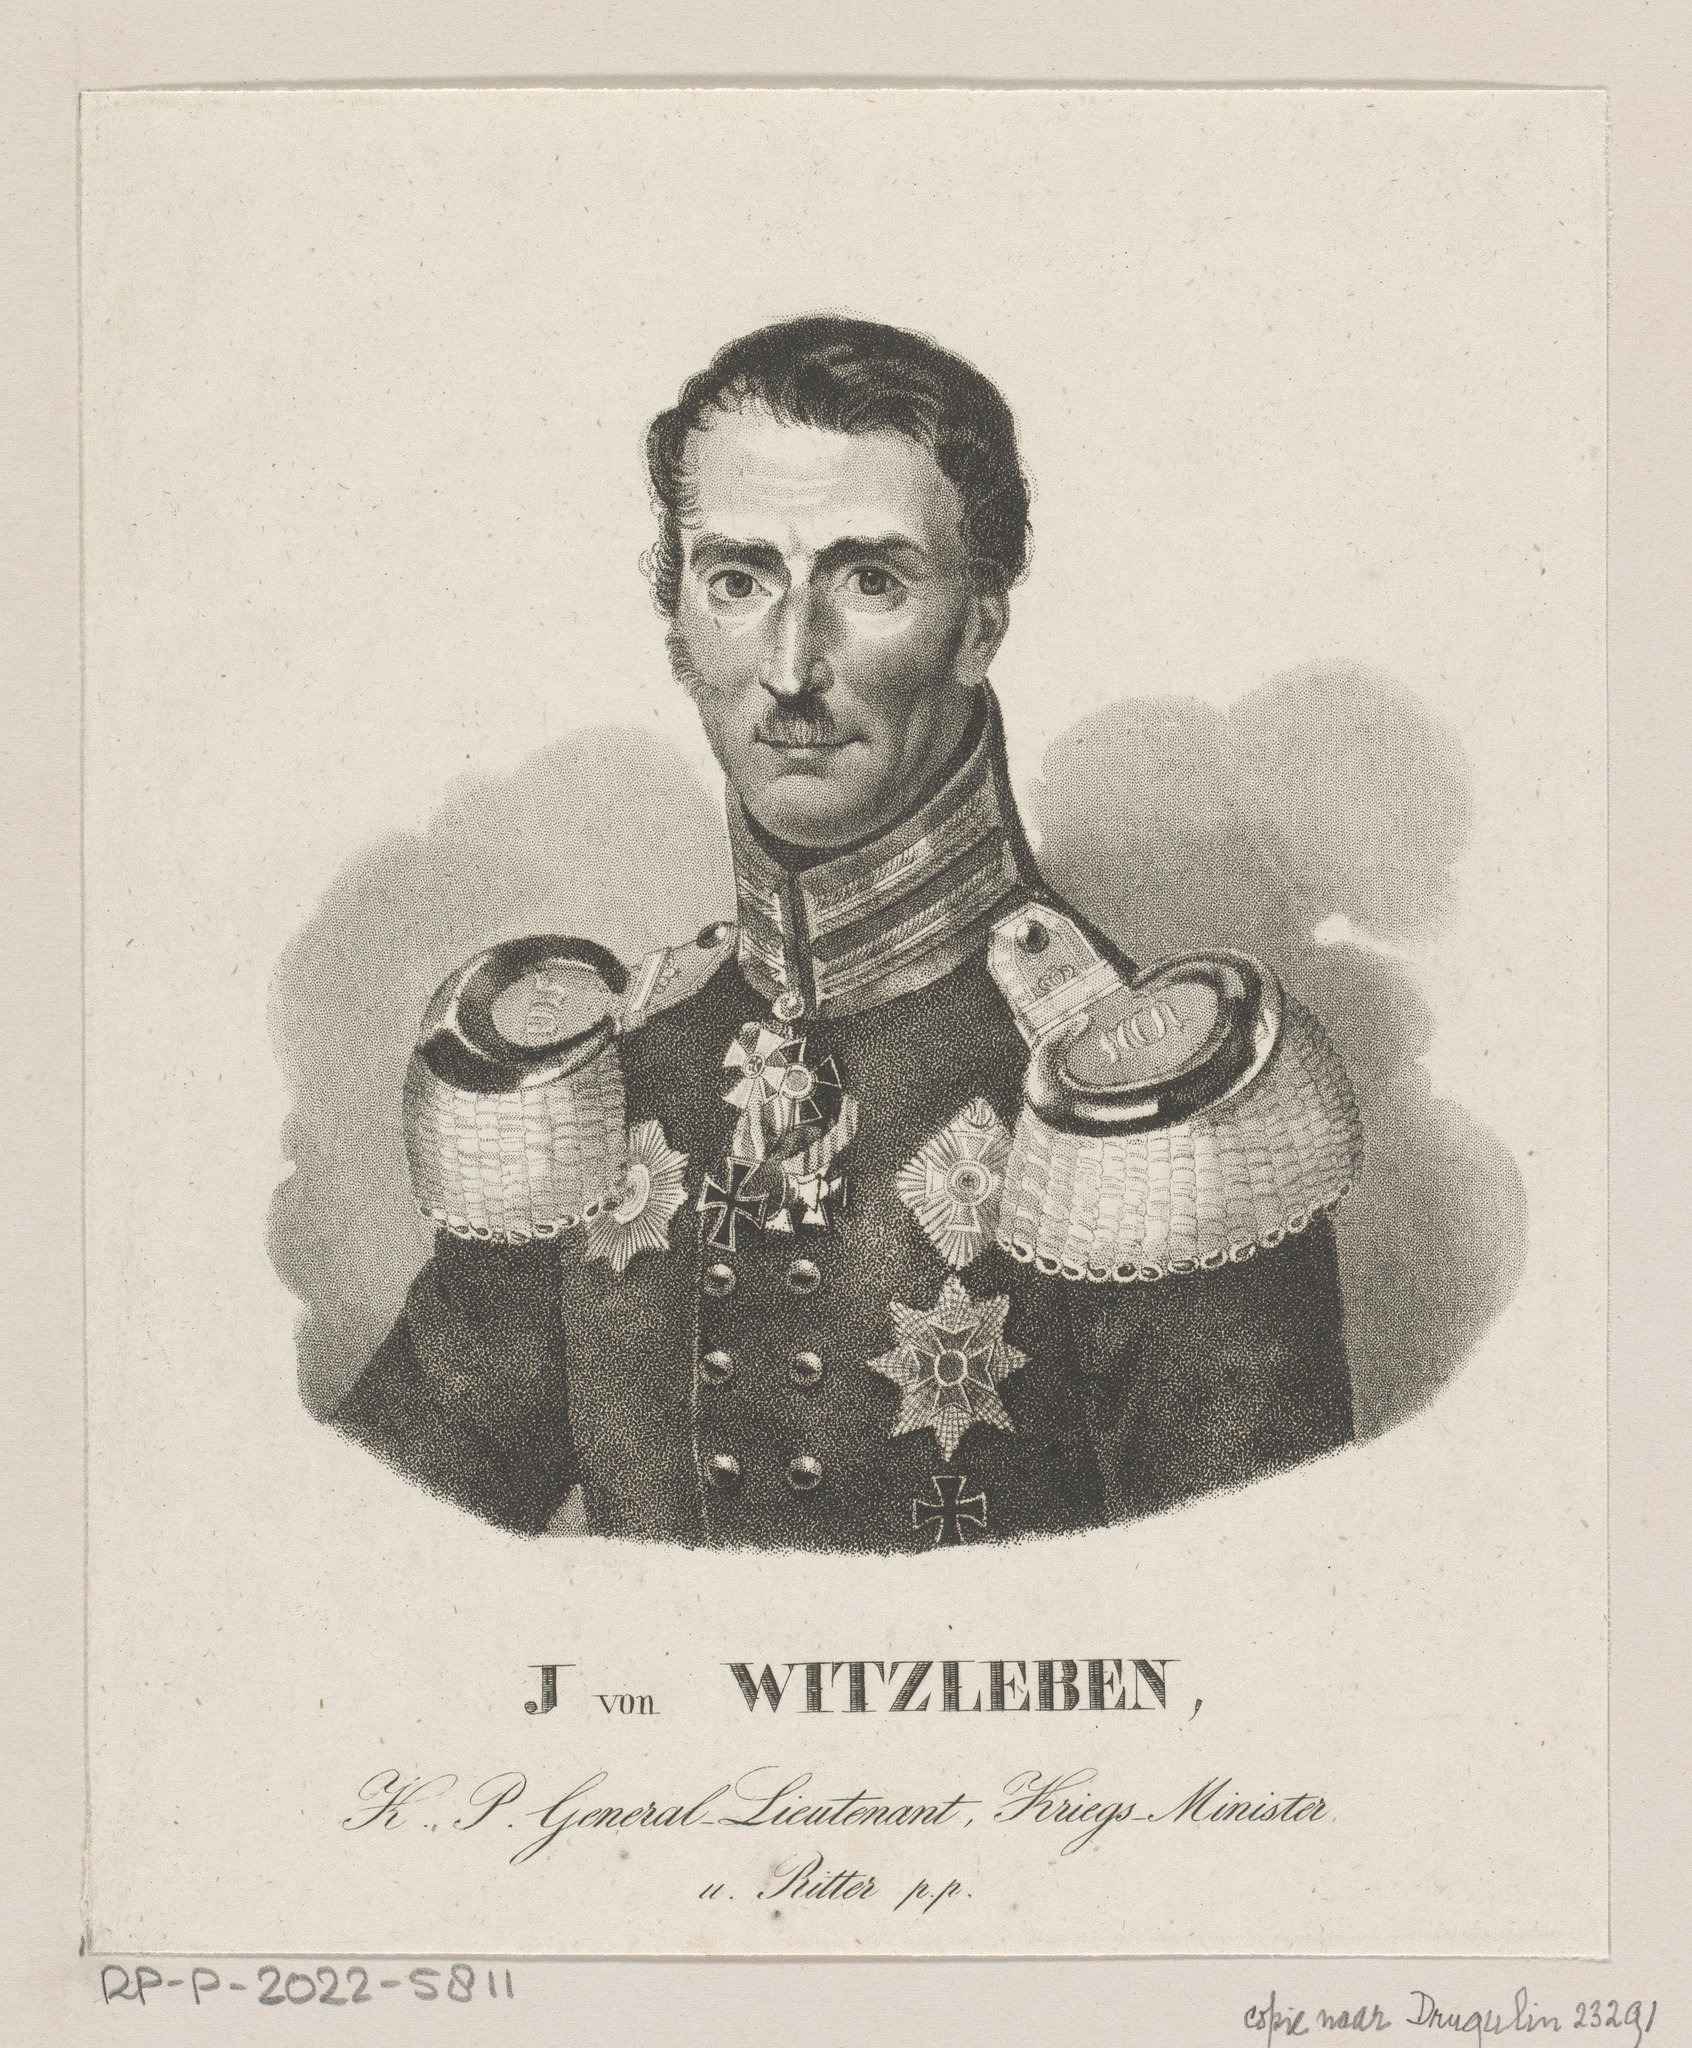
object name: print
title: Portret van Job von Witzleben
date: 1833-1843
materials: paper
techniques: stippling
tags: moustache, commander-in-chief, general, marshal, historical persons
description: Met tweeregelig onderschrift in het Duits.